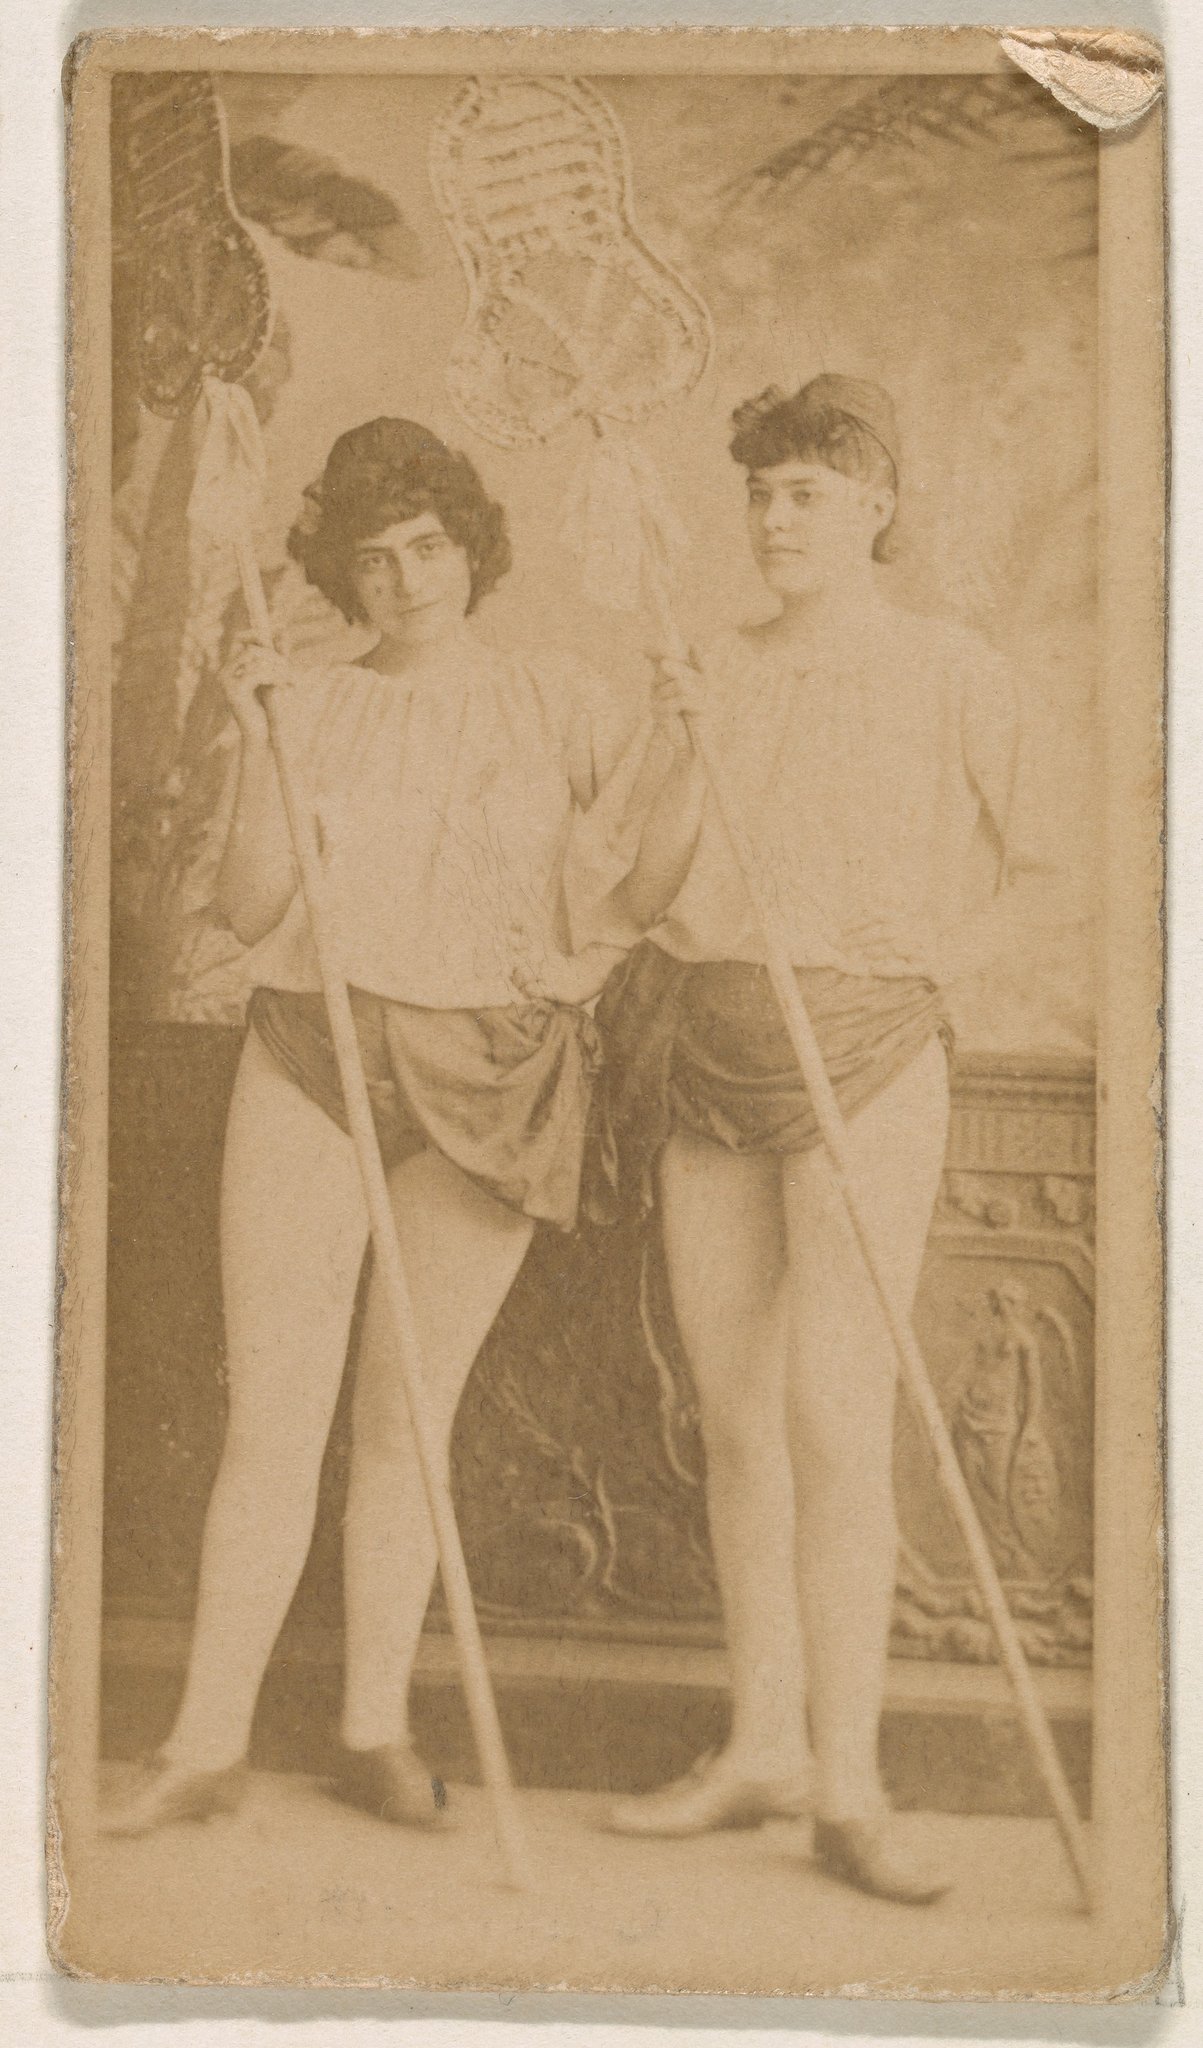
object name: photograph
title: Two actresses holding long poles, from the Actresses series (N245) issued by Kinney Brothers to promote Sweet Caporal Cigarettes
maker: kinney brothers tobacco company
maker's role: publisher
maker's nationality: american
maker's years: 1869-2011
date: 1890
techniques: albumen silver print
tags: portraits,women,actresses